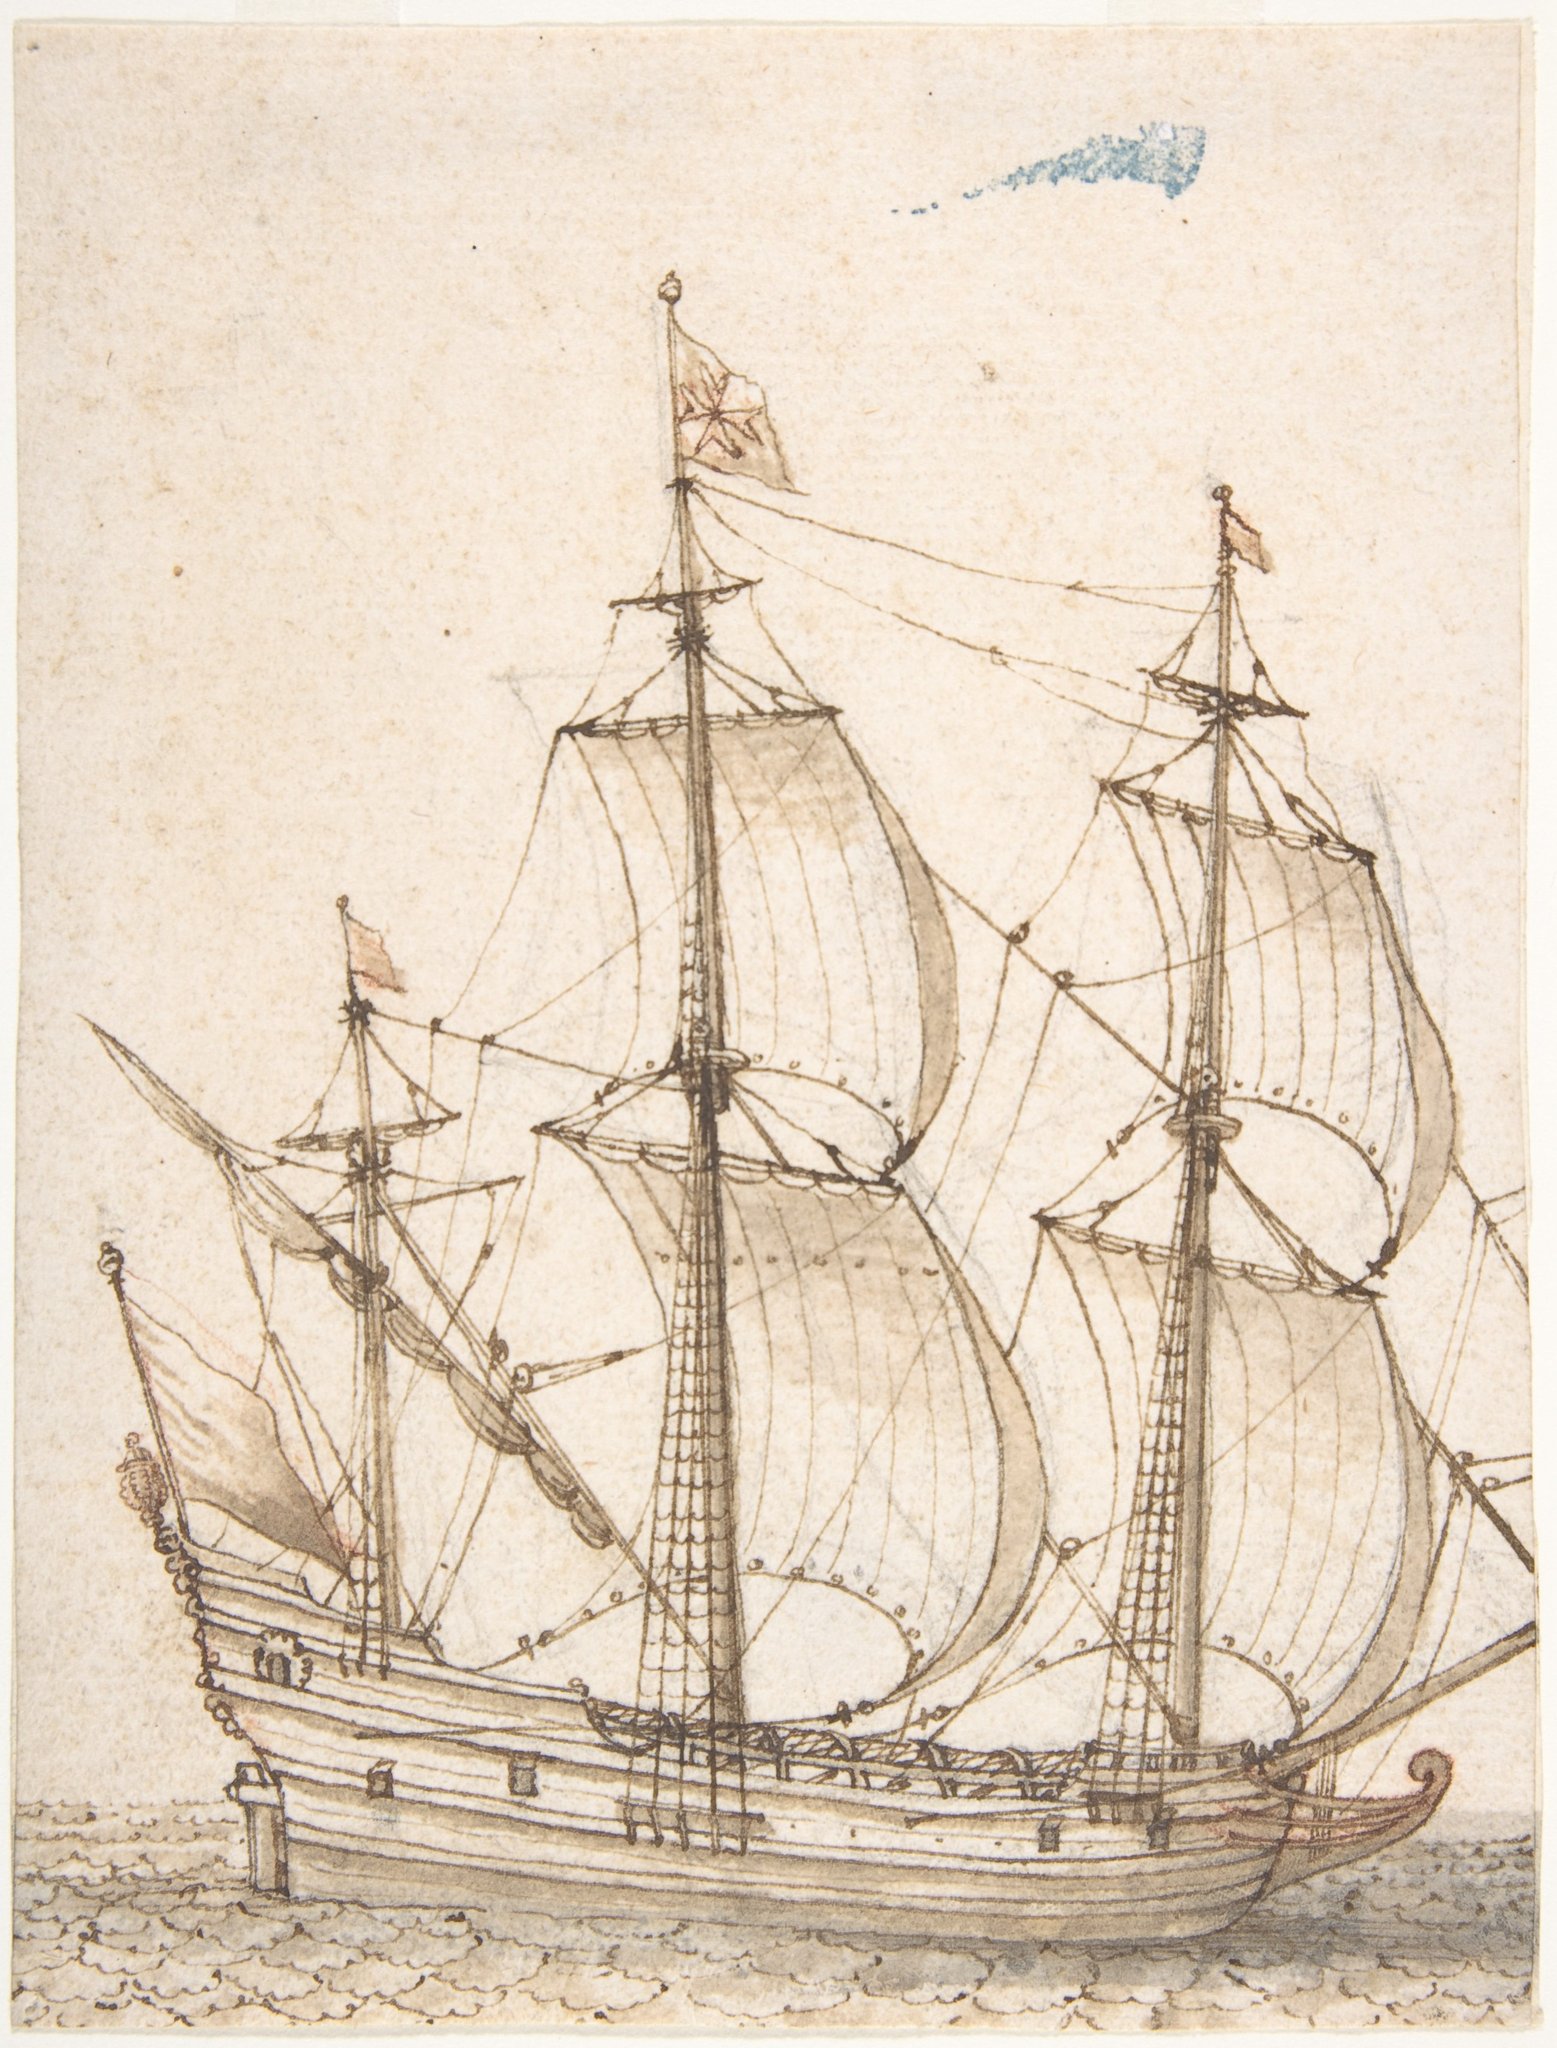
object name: drawing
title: Old Ship Model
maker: willem van de velde (i)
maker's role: artist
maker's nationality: dutch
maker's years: 1611-1693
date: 1601-1700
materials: chalk, ink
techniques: brush, pen, wash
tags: ships